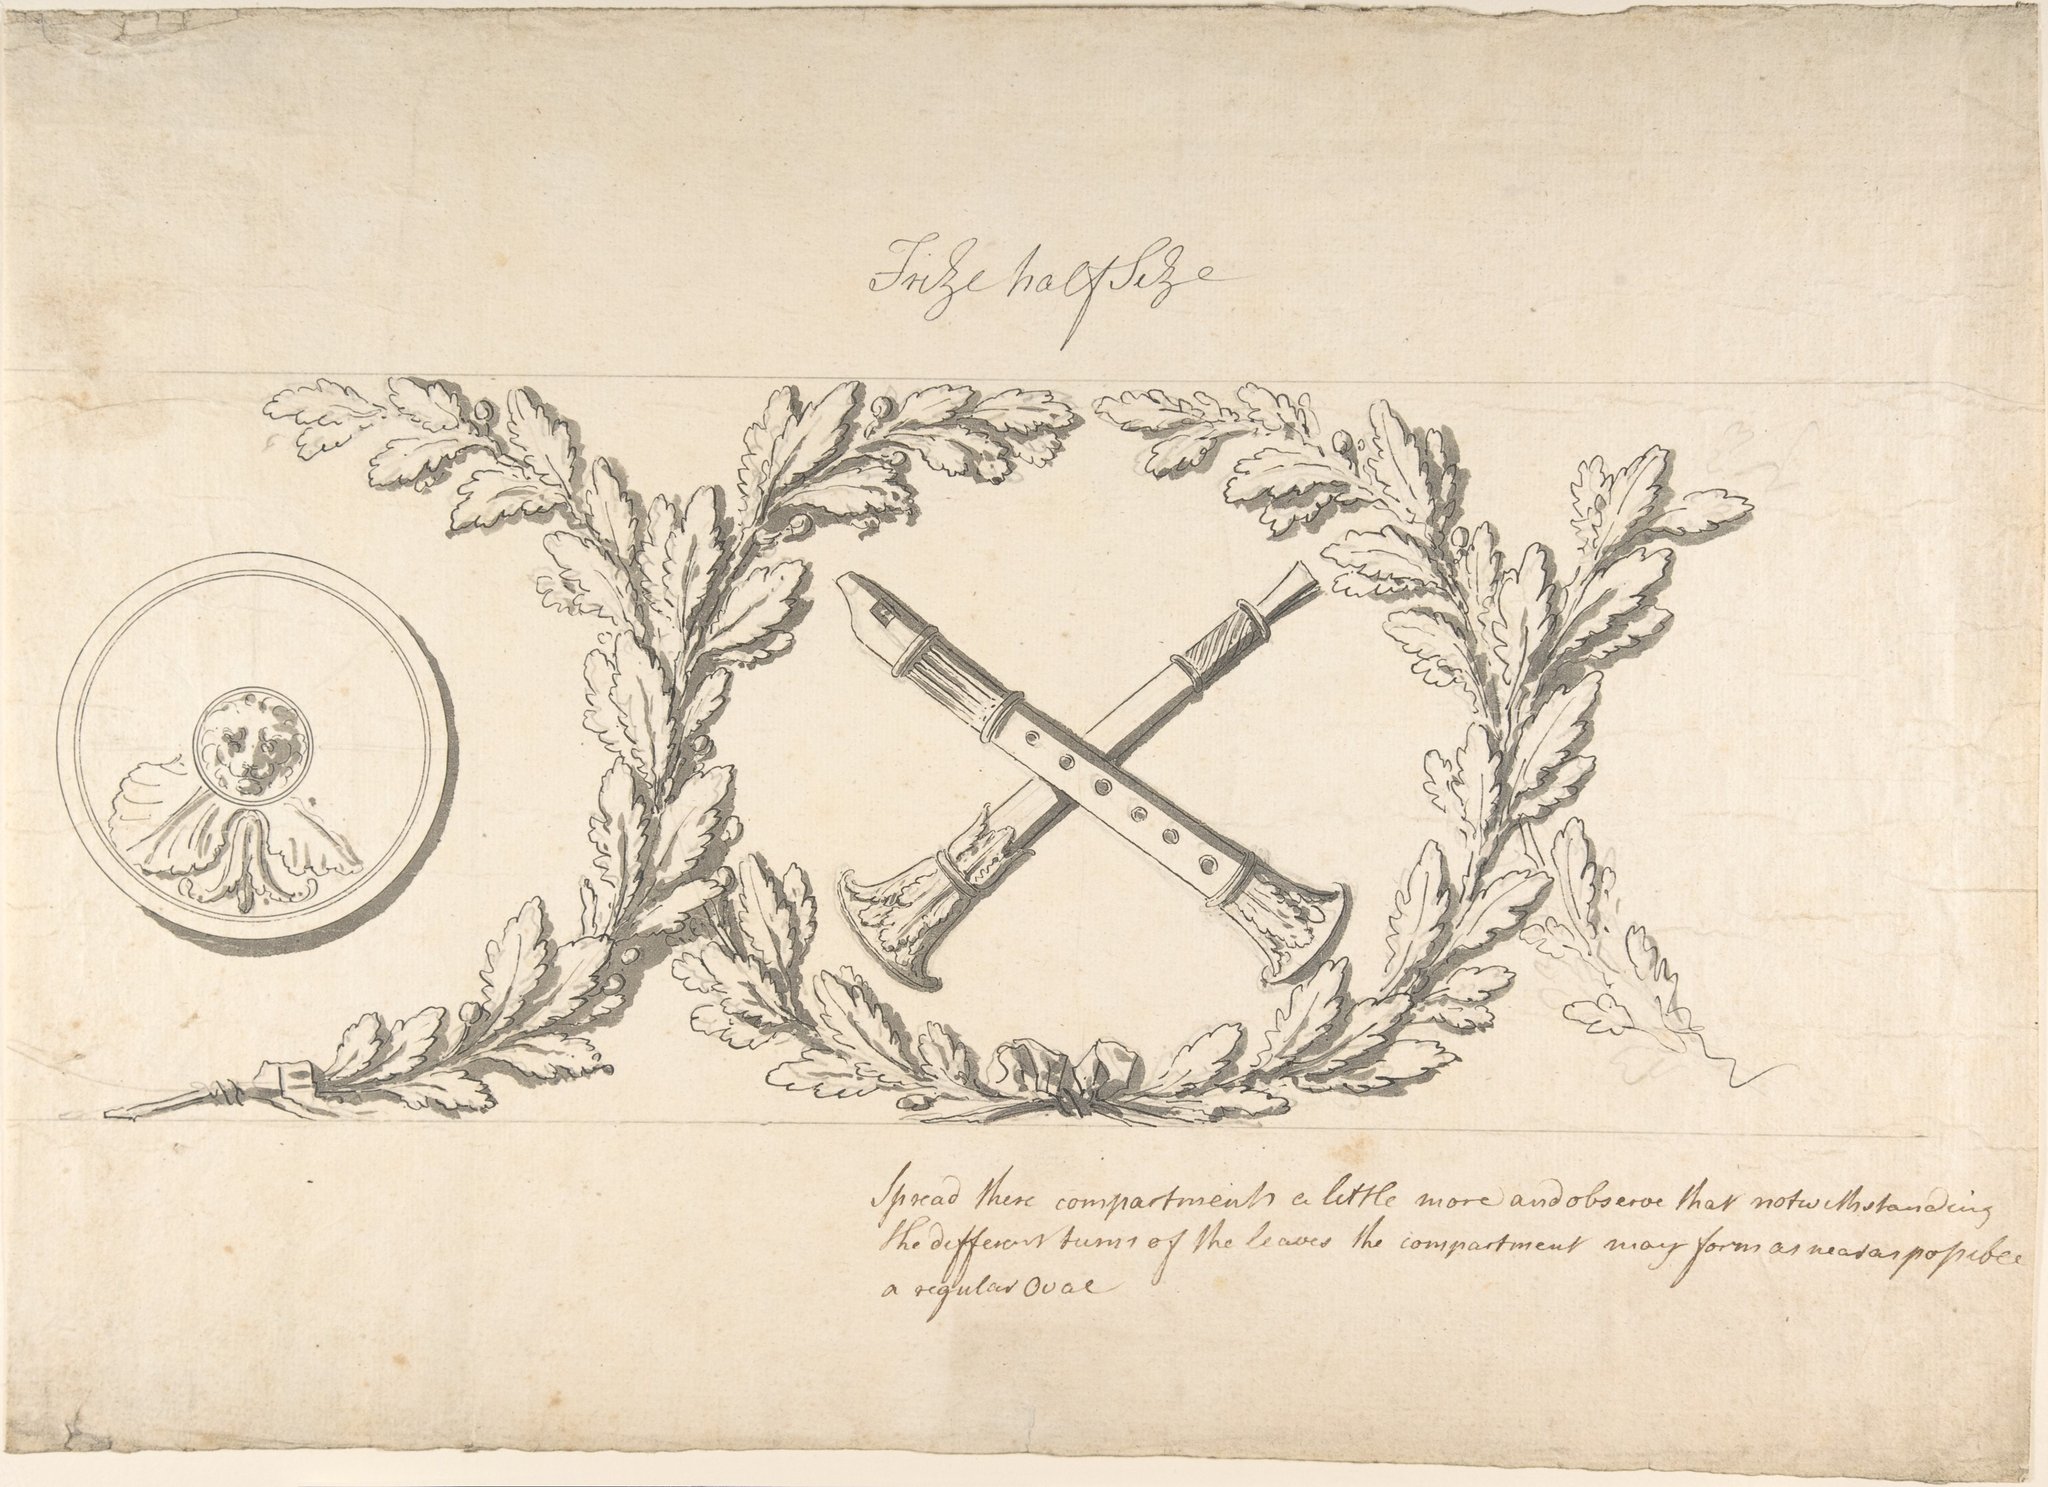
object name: drawing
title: Design for a Frieze Ornamented with Musical Instruments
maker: thomas hardwick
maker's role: artist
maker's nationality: british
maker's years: 1752-1829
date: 1767-1833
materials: ink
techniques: brush, pen, wash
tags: ornament,flutes